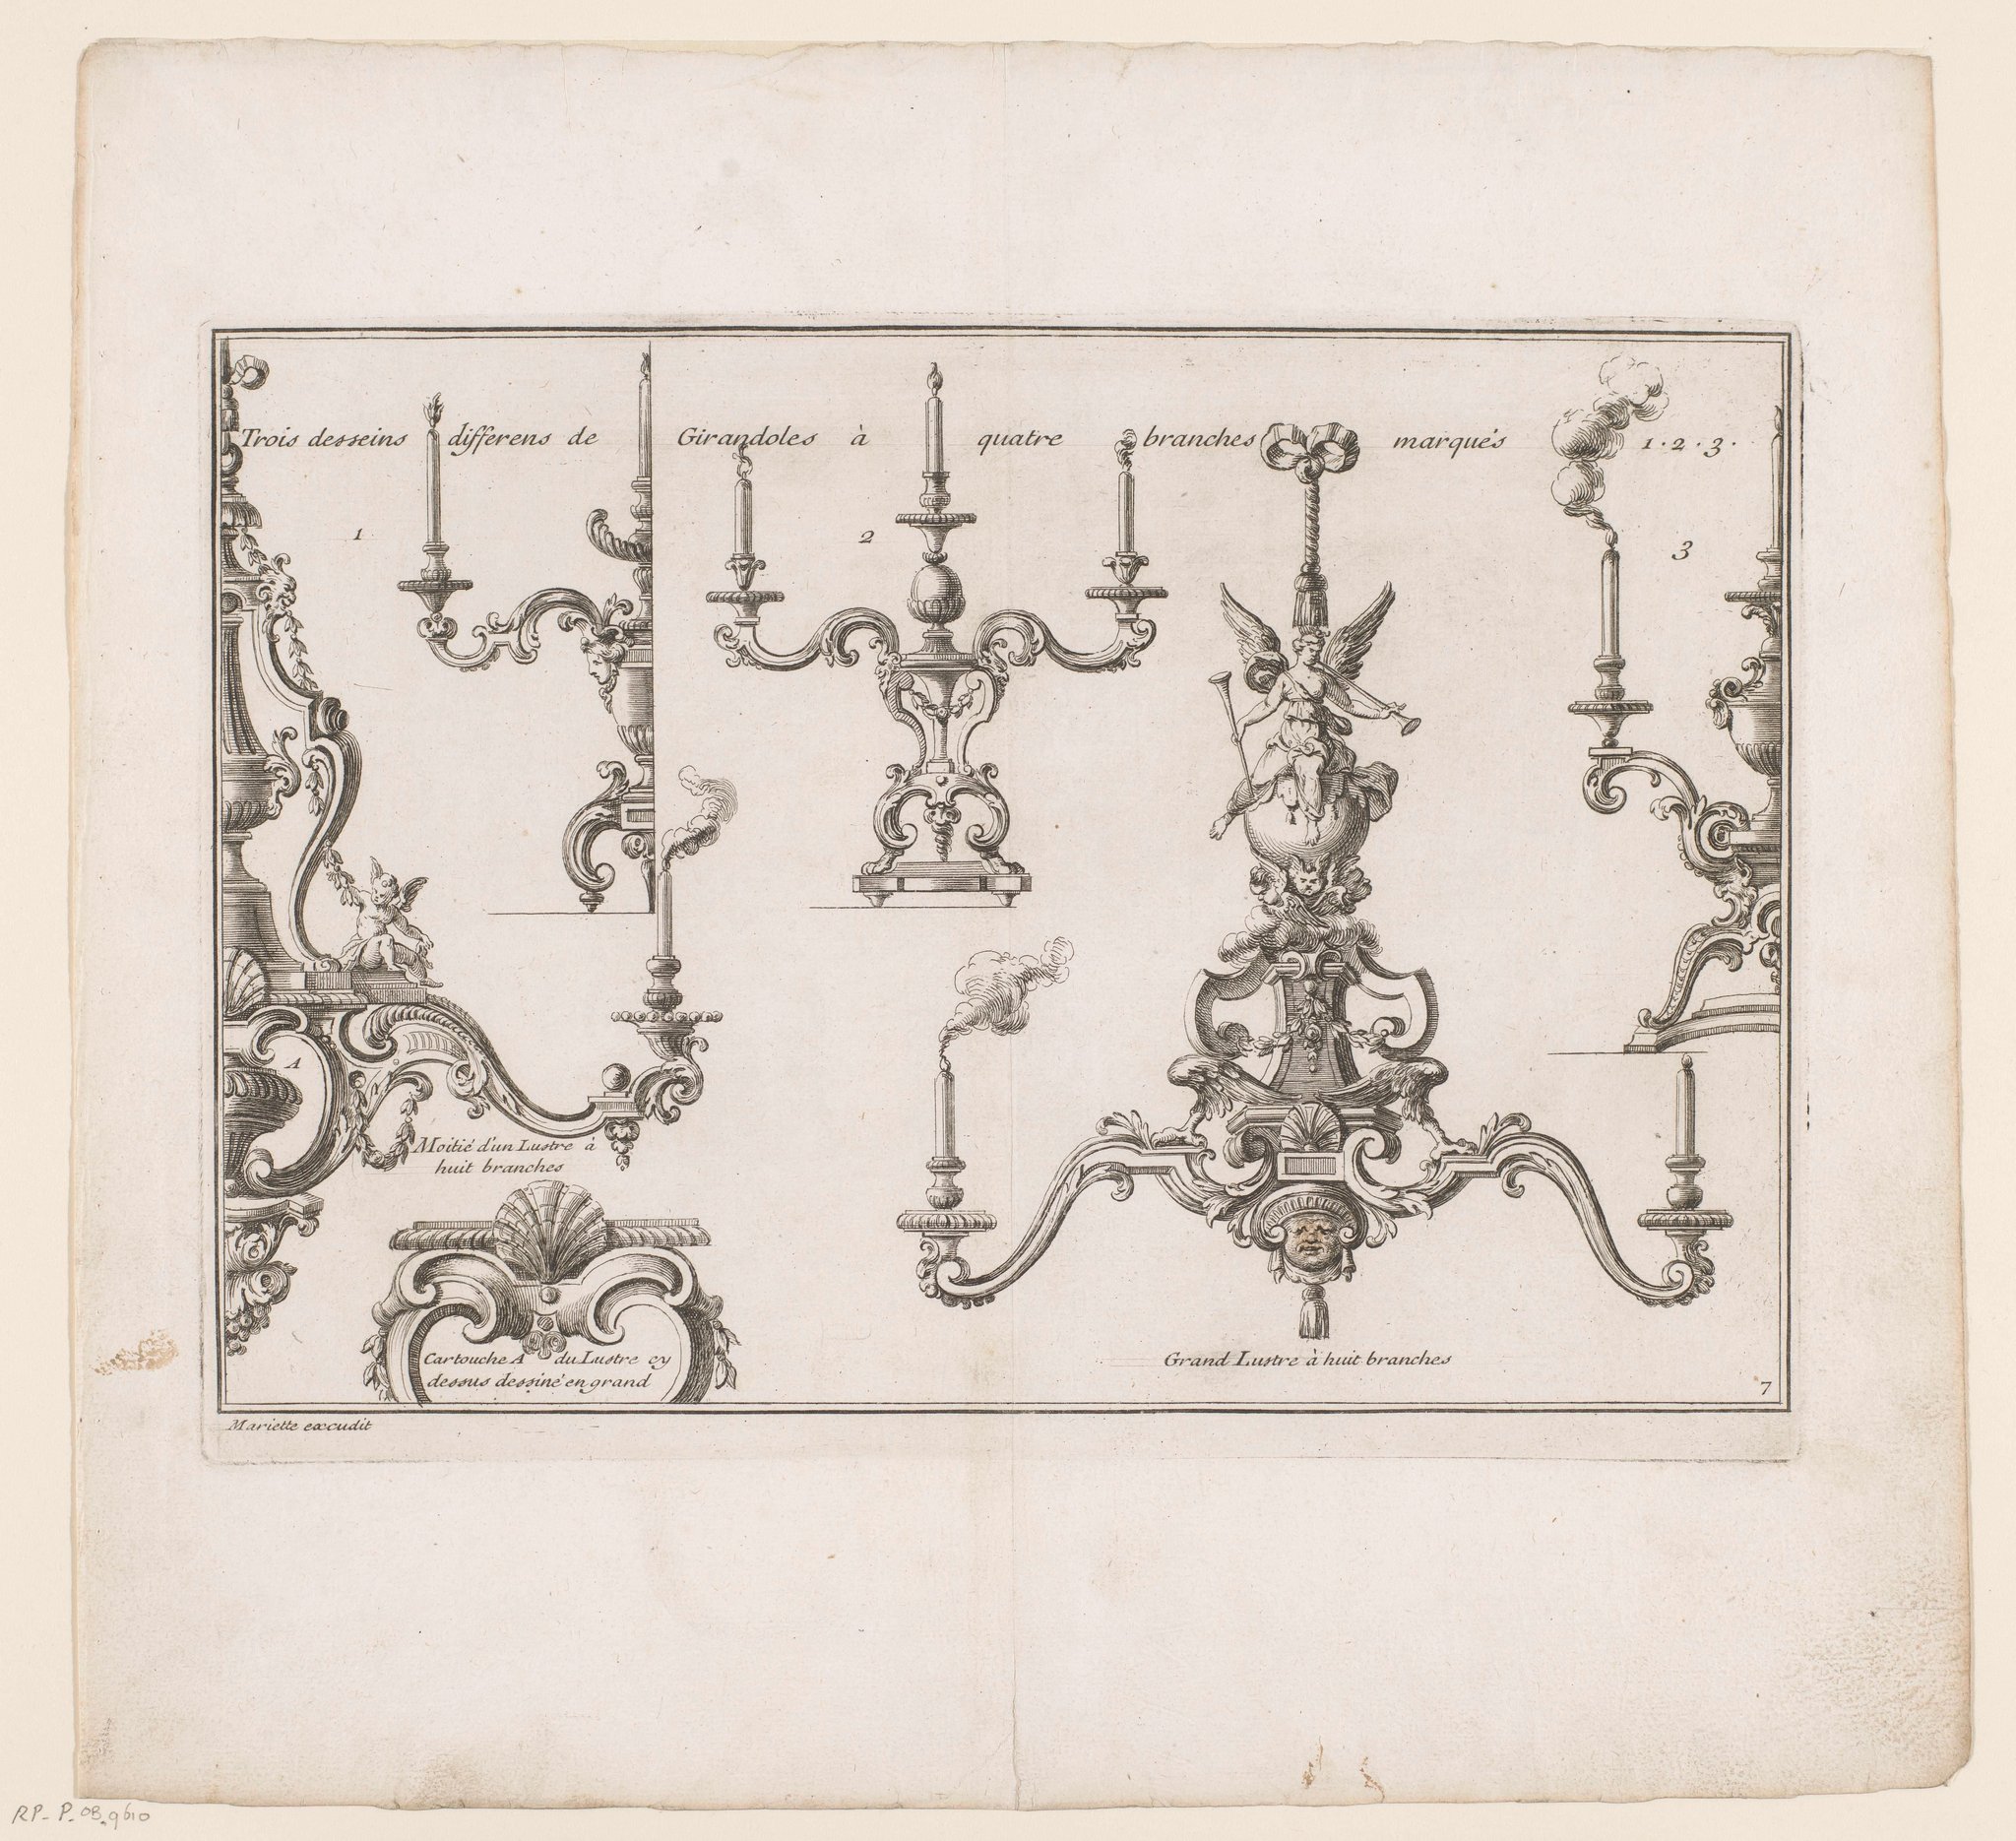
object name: print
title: Trois deisseins differens de Girandoles à quatre branches marqués 1.2.3.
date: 1710-1720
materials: paper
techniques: etching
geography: paris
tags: chandelier, candelabrum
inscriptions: collector's mark: Lugt 2228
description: Drie driearmige girandoles en twee tweearmige kroonluchters met putti en Fama. Met Franse bijschriften.